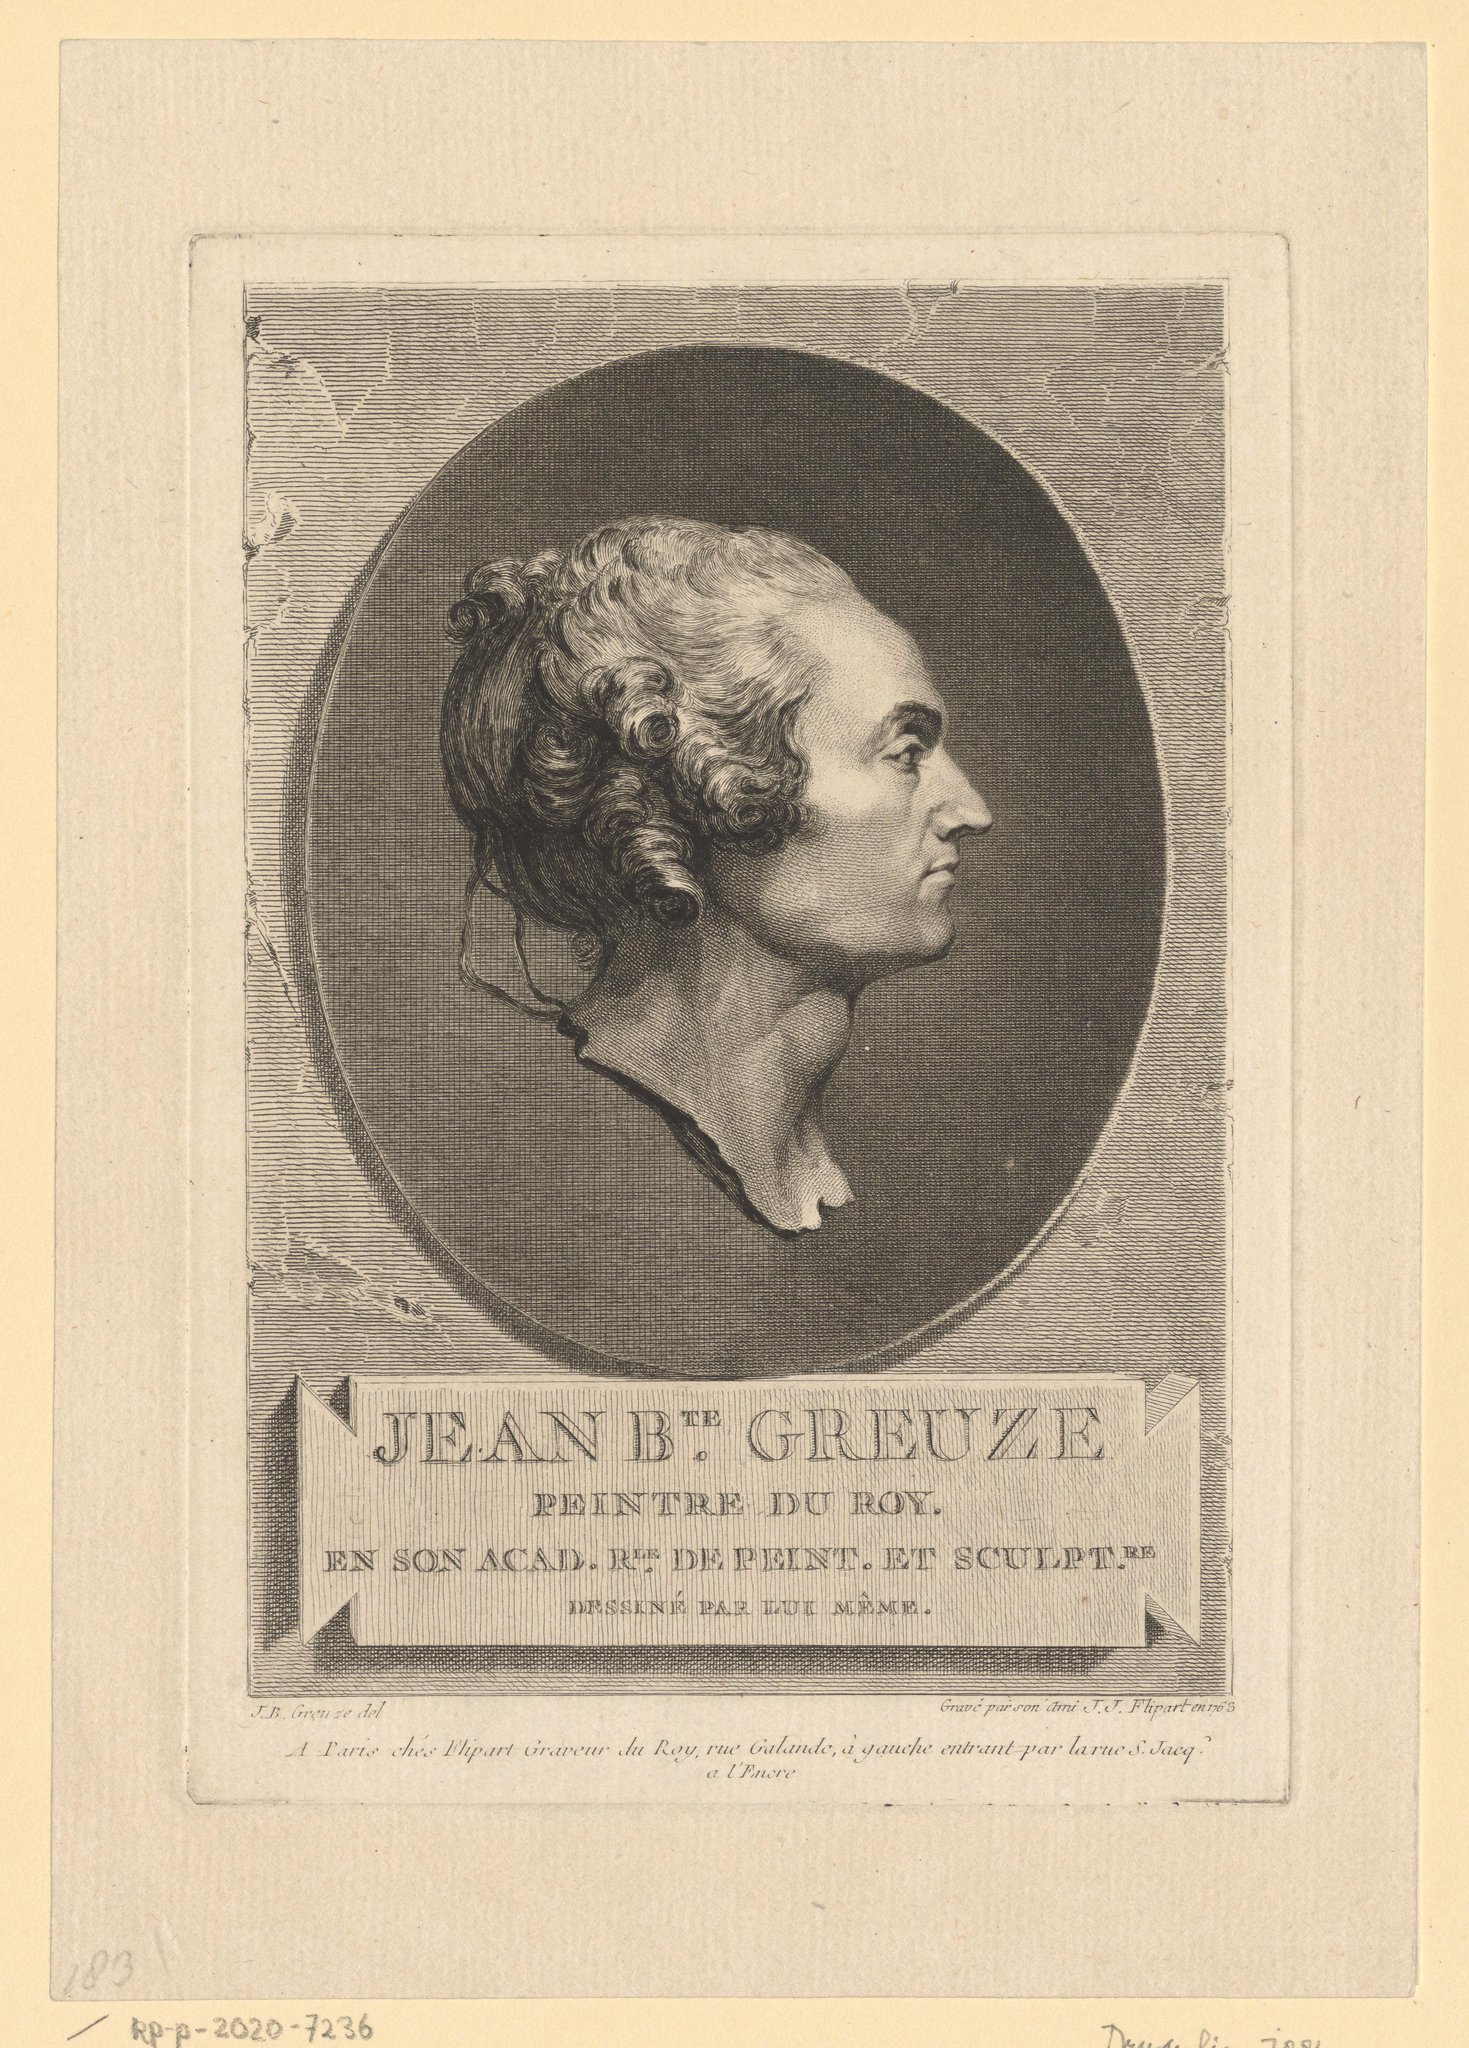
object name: print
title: Portret van Jean-Baptiste Greuze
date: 1763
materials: paper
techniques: engraving, etching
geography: paris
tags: paris, painter, jean-baptiste greuze, historical persons, portrait, self-portrait of painter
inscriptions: date